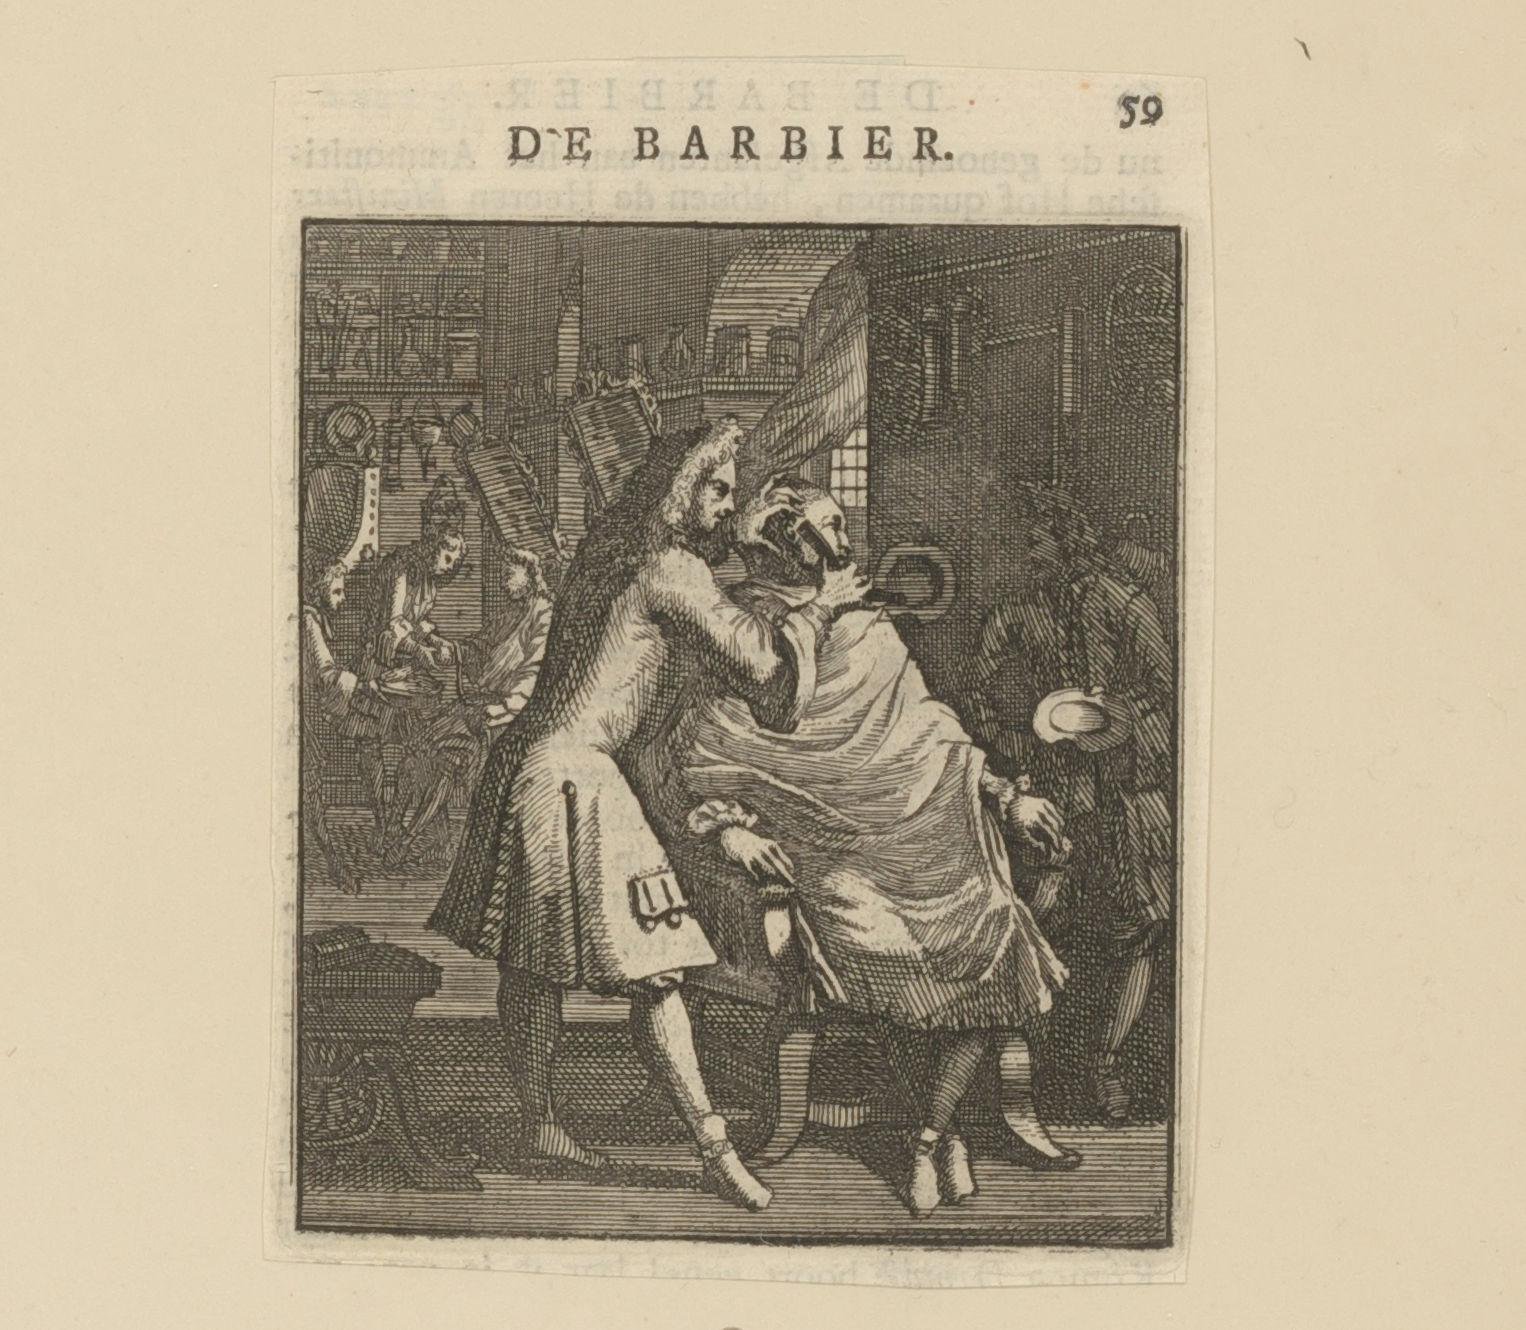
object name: print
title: De Barbier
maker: Anonymous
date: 1719-1759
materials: paper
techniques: etching, letterpress printing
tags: razor, shaving, being shaved, barber, barbershop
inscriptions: collector's mark: Lugt 1641, stamp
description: Prent met andere letterzetting gebruikt in: St. Clara, Abraham van. Iets voor allen. [Vertaald door] J. le Long. Amsterdam: Janssoons van Waesberge, 1719, dl. 2. En in: St. Clara, Abraham van. Iets voor allen. [Vertaald door] J. le Long. Amsterdam: Jan Roman de Jonge, 1741, dl. 2. En in: St. Clara, Abraham van. Iets voor allen. [Vertaald door] J. le Long. Amsterdam: Jan Roman, 1759, dl. 2. Huidige prent uit een andere editie. Naar een prent van: Jan Luyken.